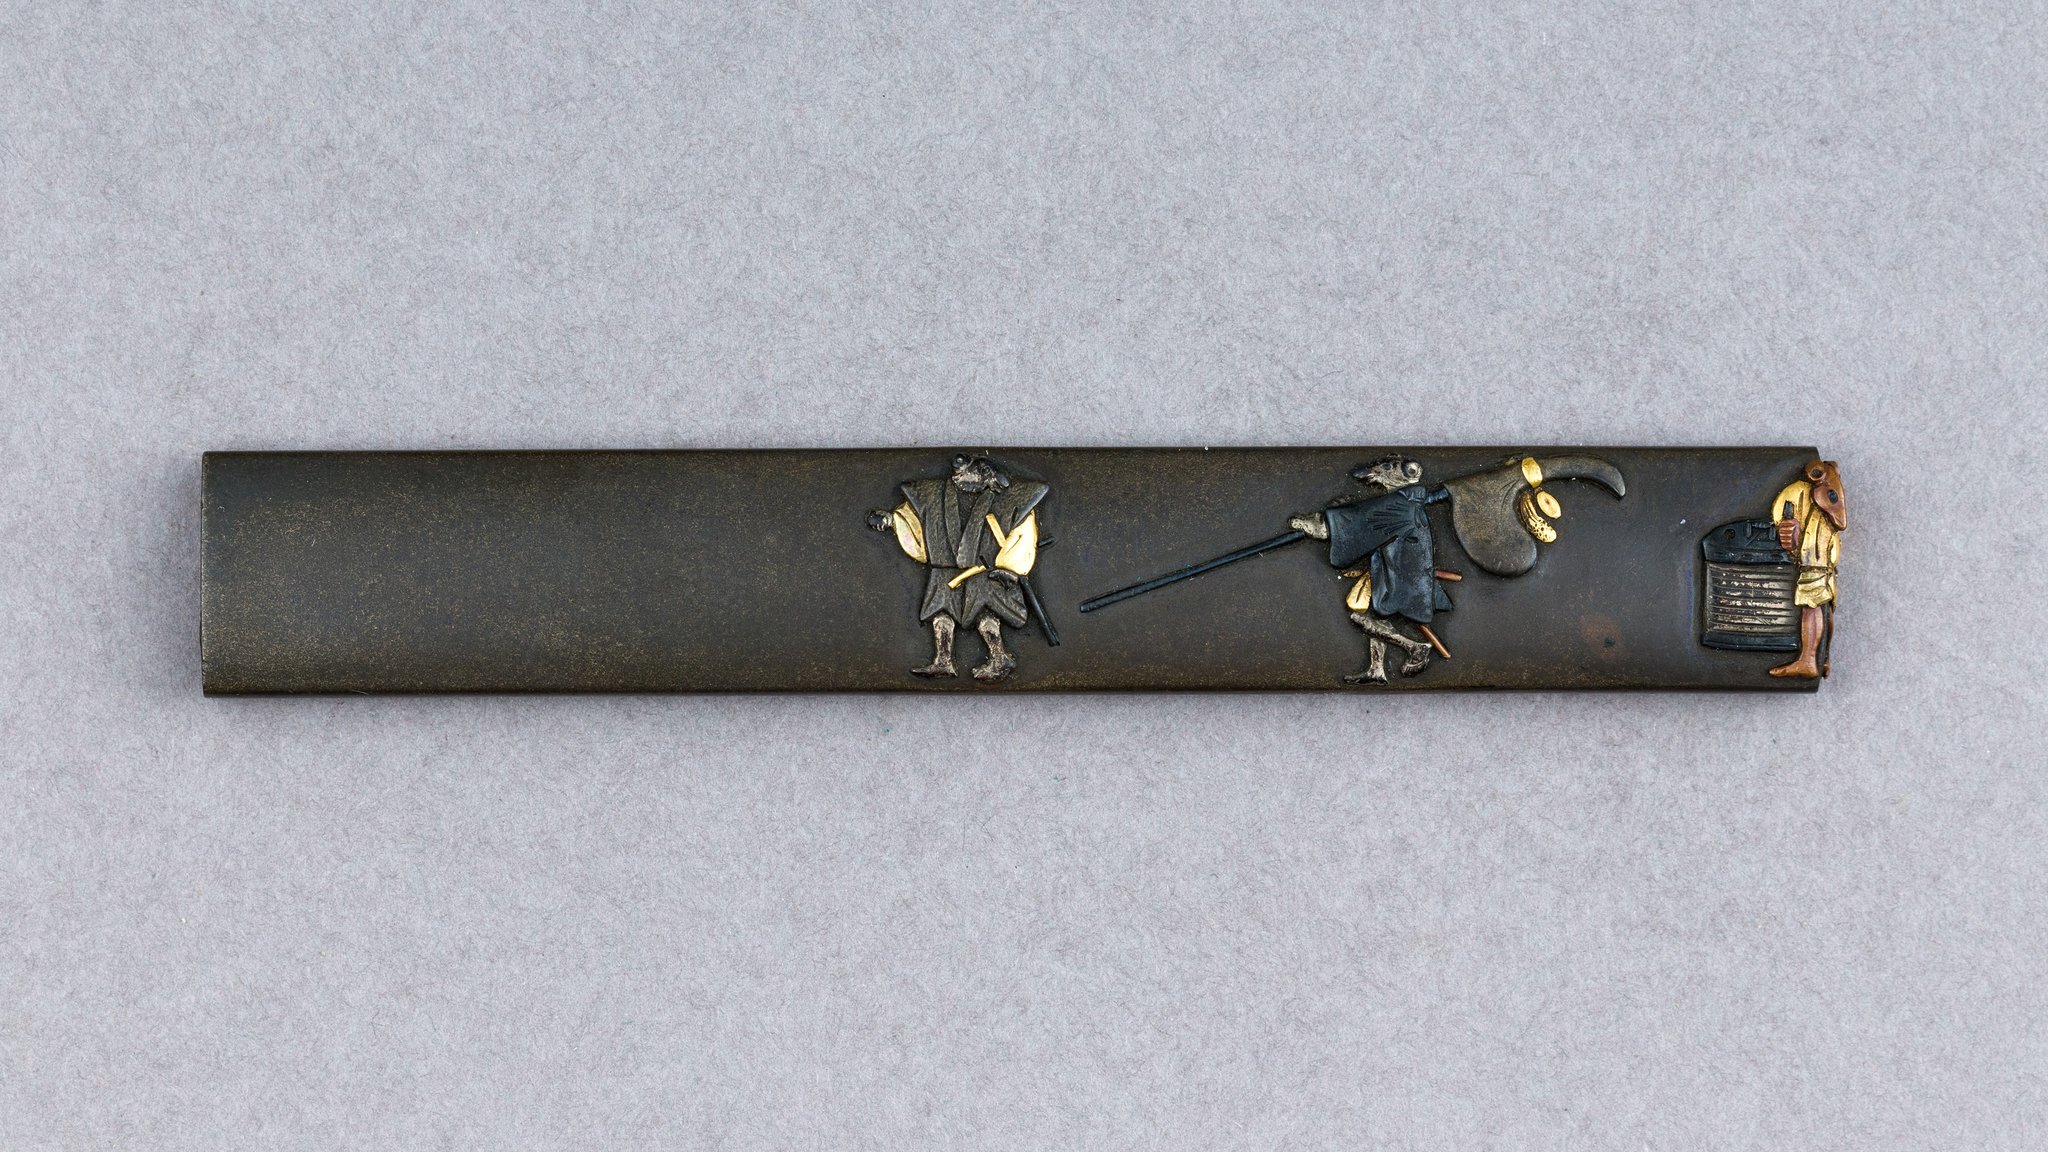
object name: knife handle kozuka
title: Knife Handle (Kozuka)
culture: japanese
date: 1615-1868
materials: copper, gold alloy, silver alloy, gold, silver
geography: japan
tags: mice